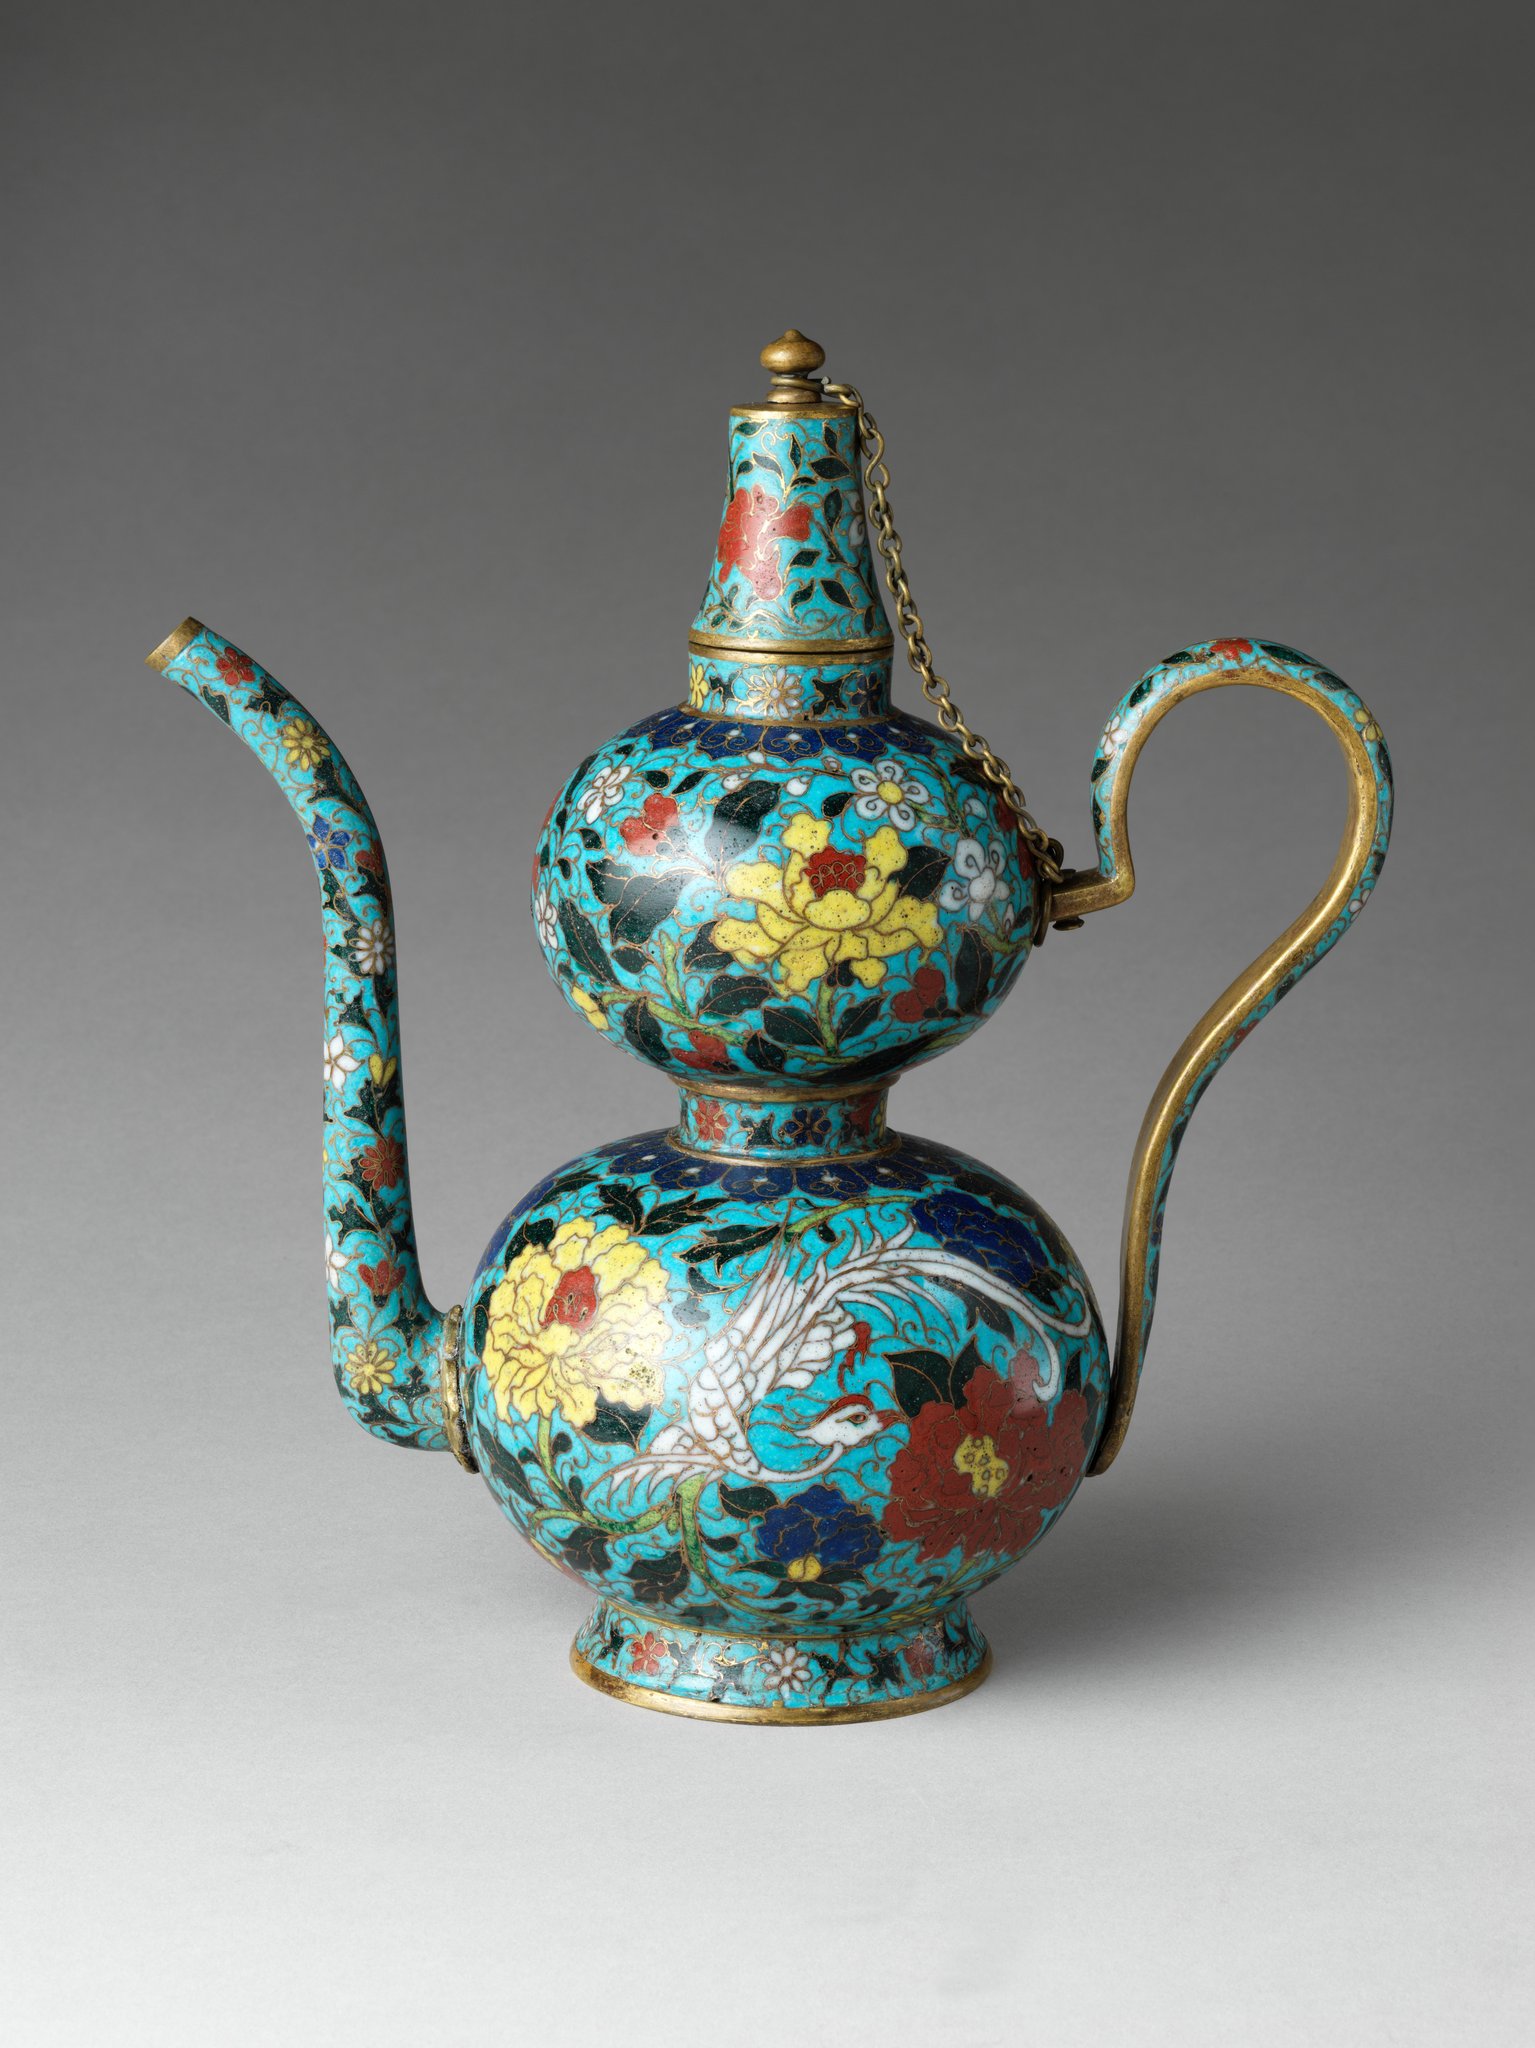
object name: ewer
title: Double-gourd form ewer with birds and flowers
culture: chinese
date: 1501-1600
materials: enamel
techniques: enamel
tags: phoenix,flowers